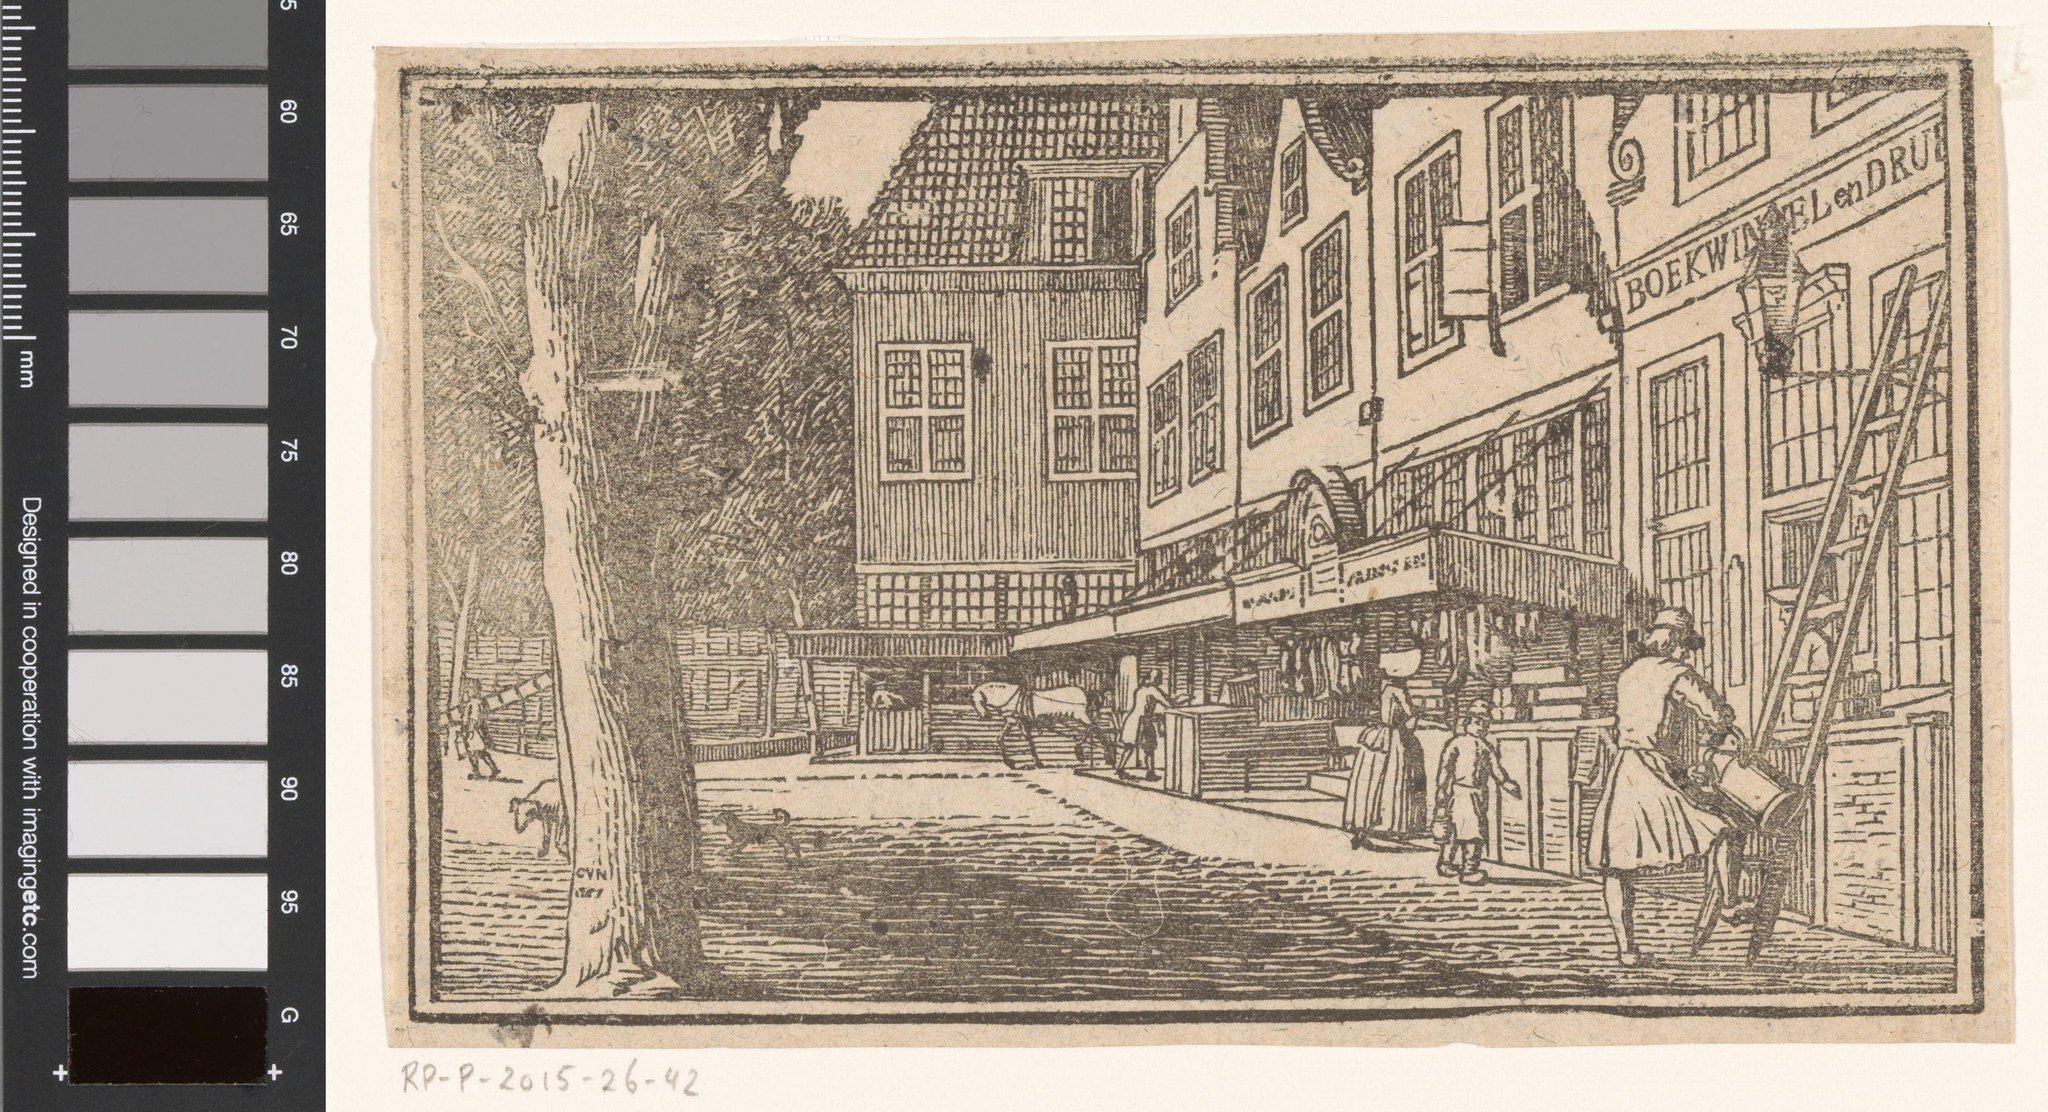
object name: print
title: Straat met boekwinkel en drukkerij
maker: cornelis van noorde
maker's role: draughtsman, print maker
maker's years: 1731-1795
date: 1761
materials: paper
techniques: woodcut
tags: city-view in general; 'veduta' (+ city(-scape) with figures, staffage), book-shop, bookseller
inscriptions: collector's mark: Lugt 2228, collector's mark: Lugt 4780